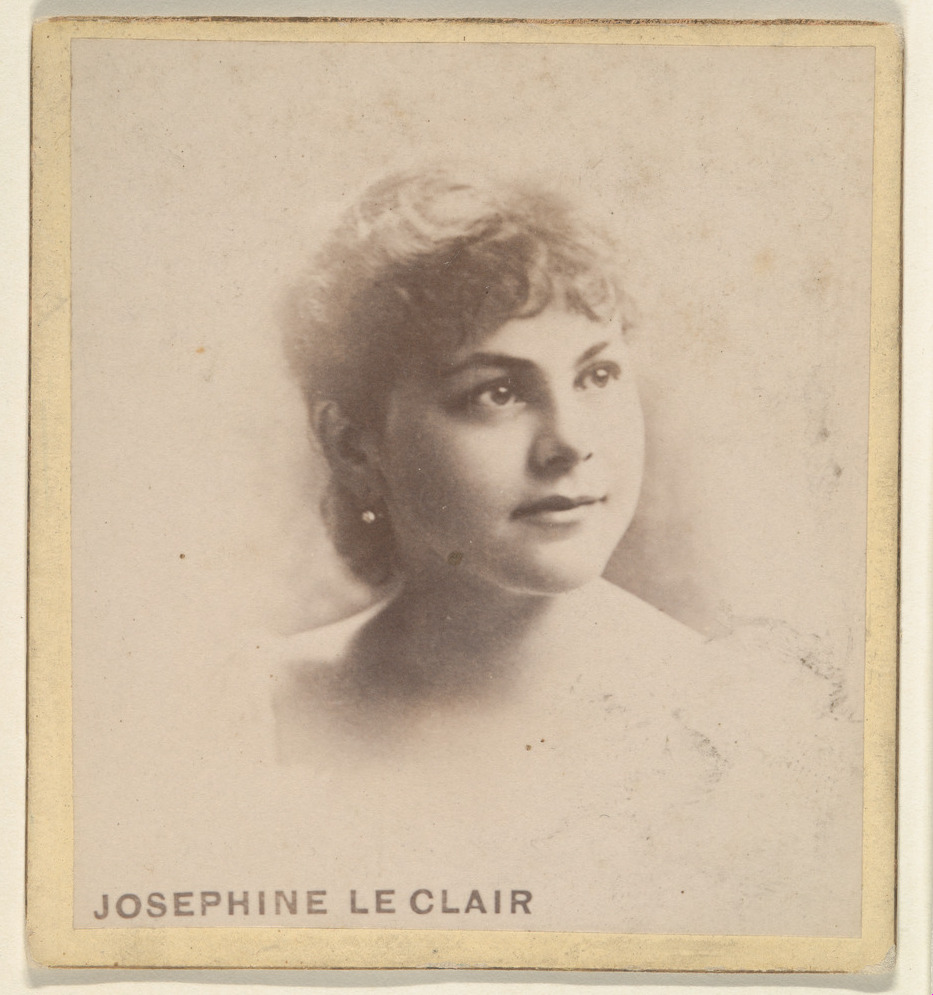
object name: photograph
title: Josephine LeClair, from the Actresses series (N246), Type 2, issued by Kinney Brothers to promote Sporting Extra Cigarettes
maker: kinney brothers tobacco company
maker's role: publisher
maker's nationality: american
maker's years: 1869-2011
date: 1890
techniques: albumen silver print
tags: portraits,women,actresses